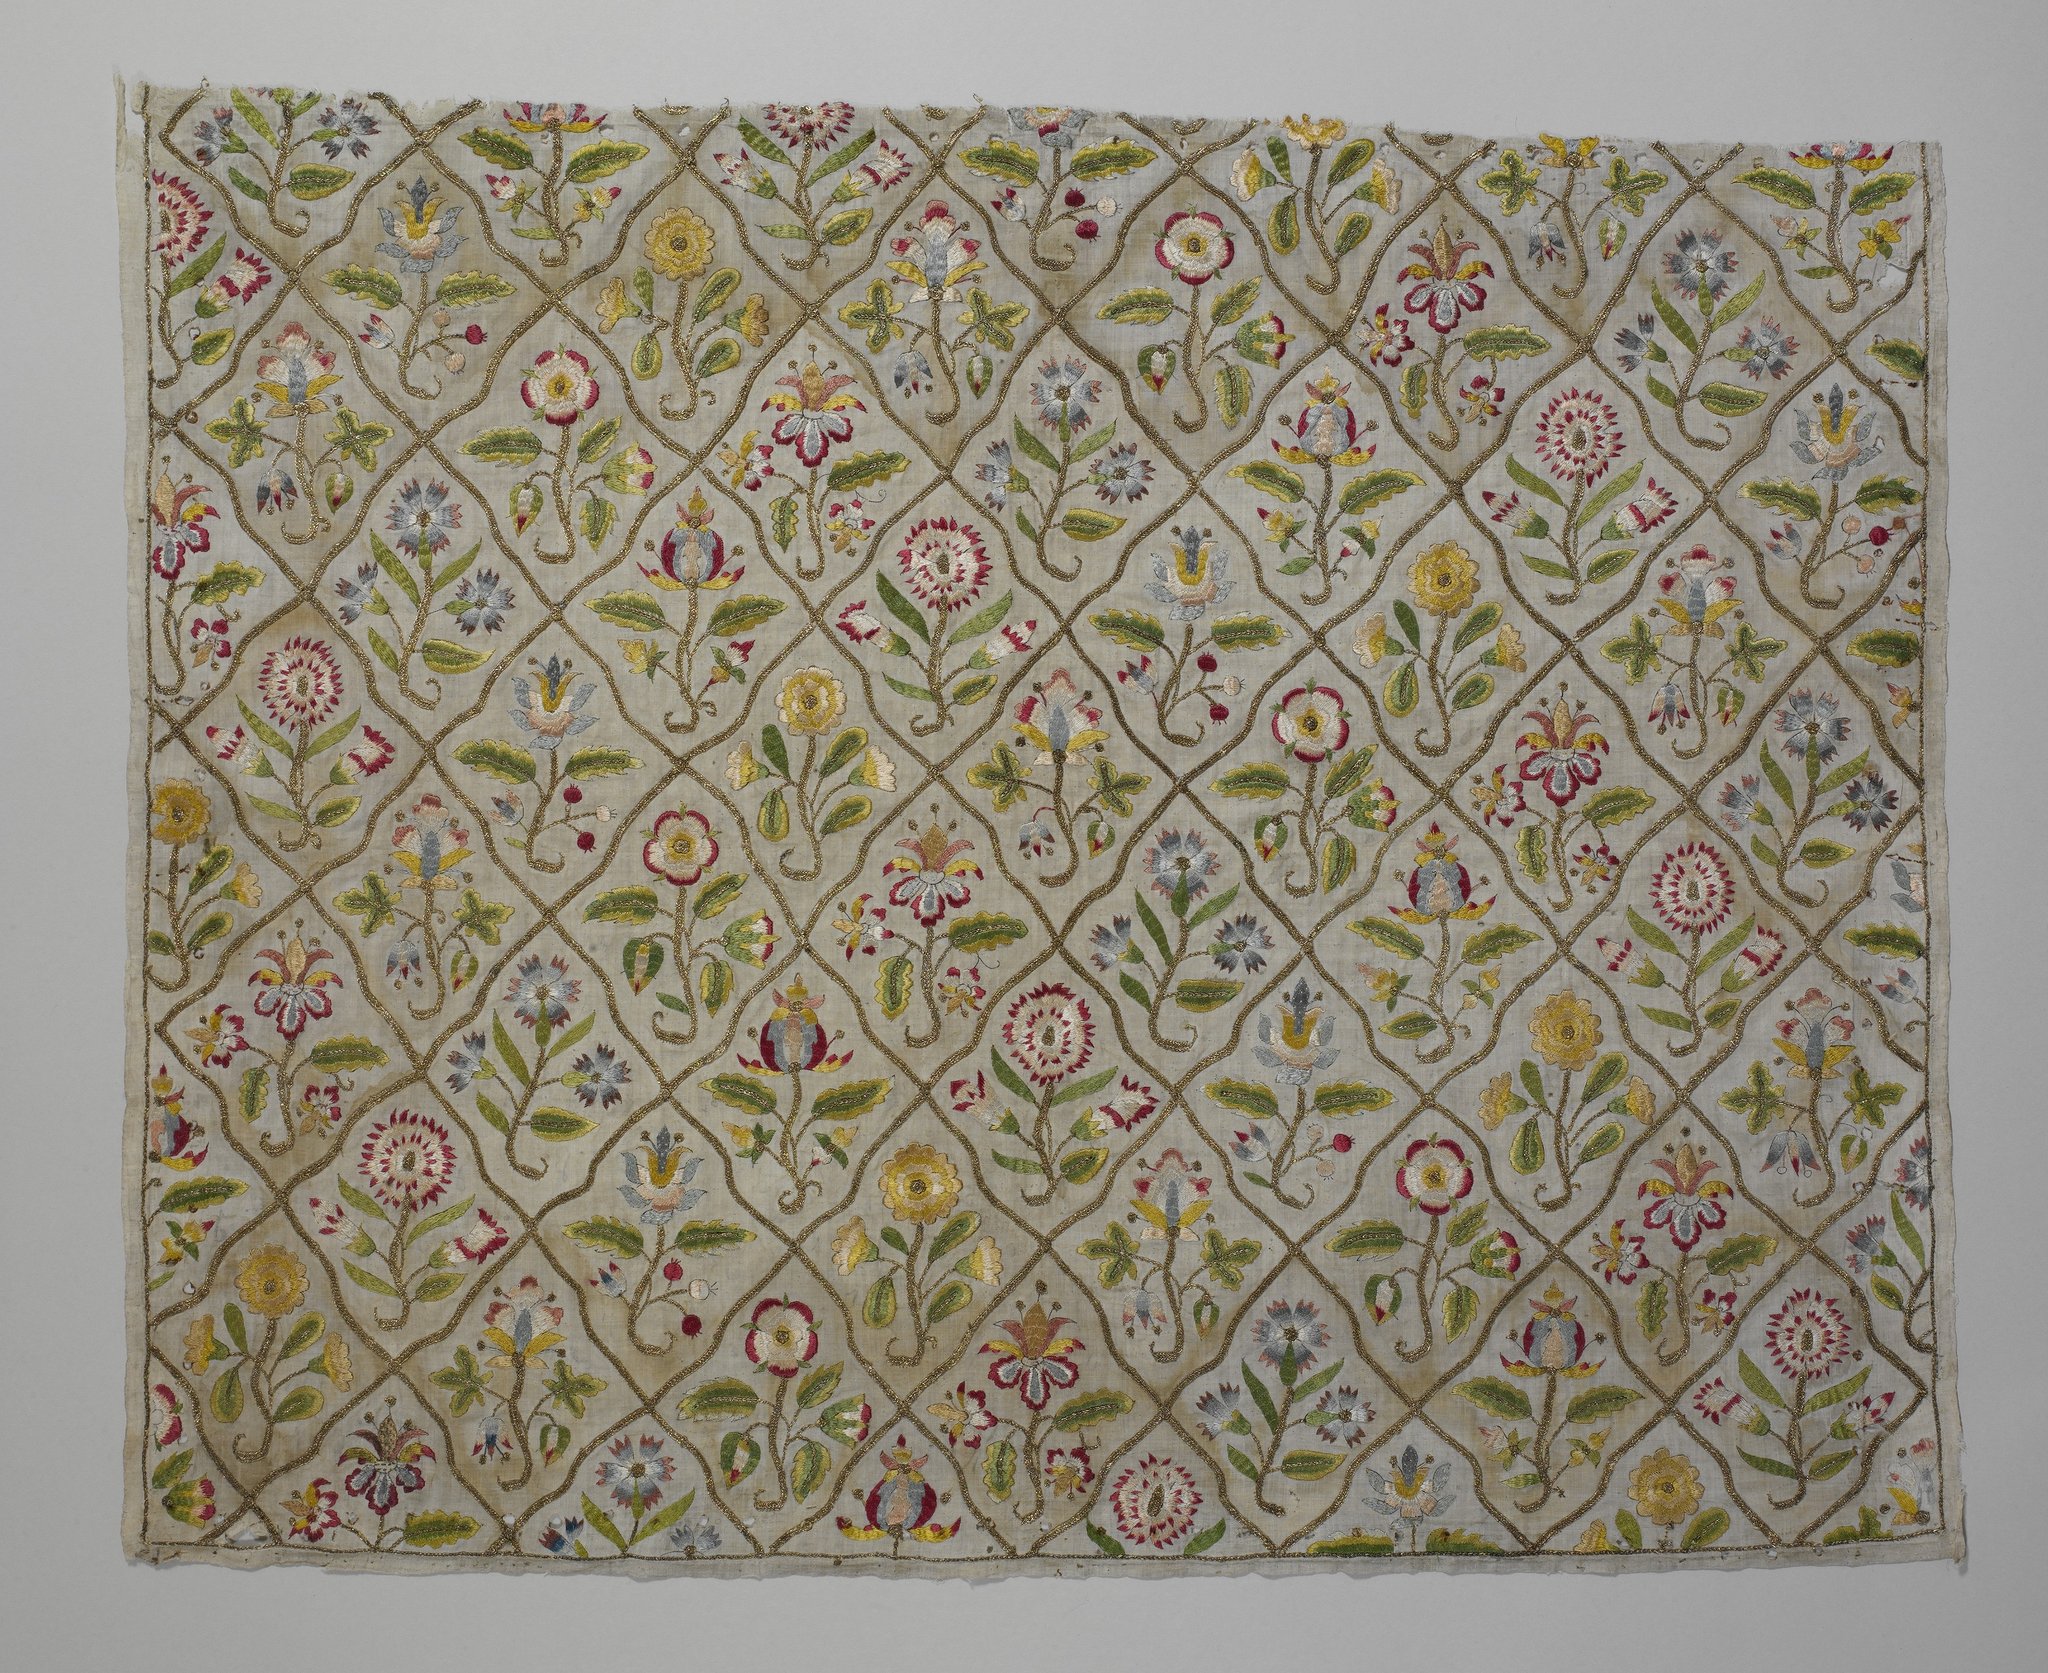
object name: panel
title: Panel with floral motifs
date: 1626-1650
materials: linen, metal thread, silk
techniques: stitching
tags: flowers